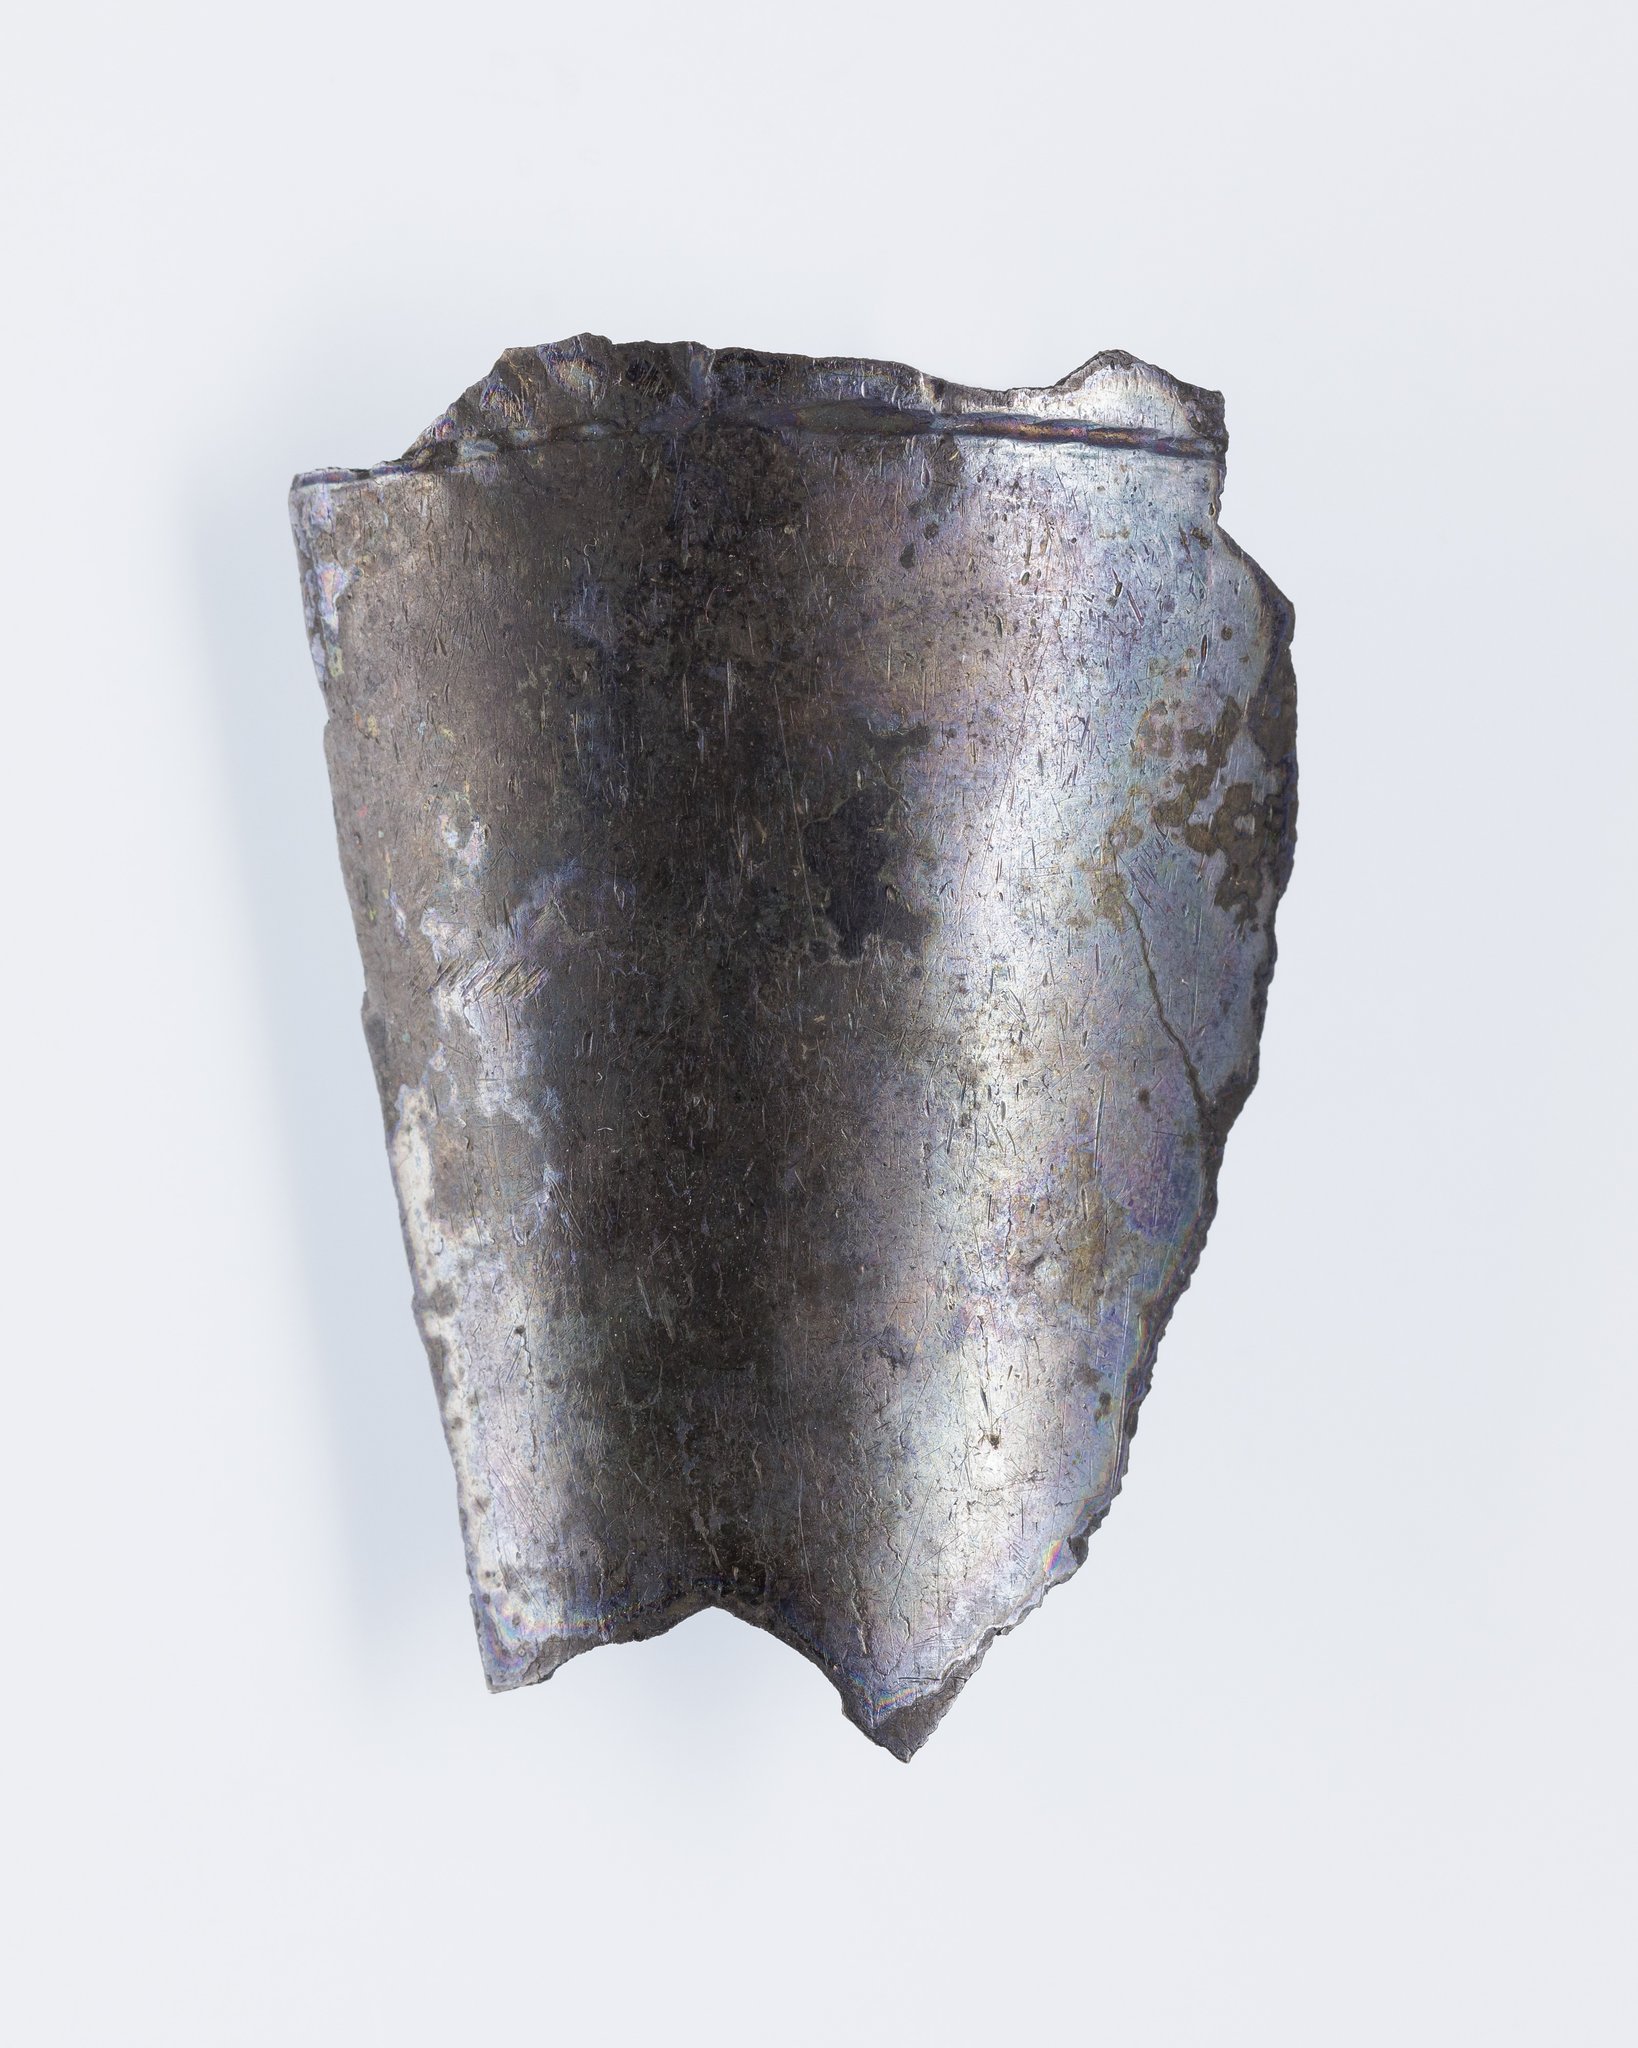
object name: situla fragment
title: Body fragment from a situla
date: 1295-1070 BCE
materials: silver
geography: egypt